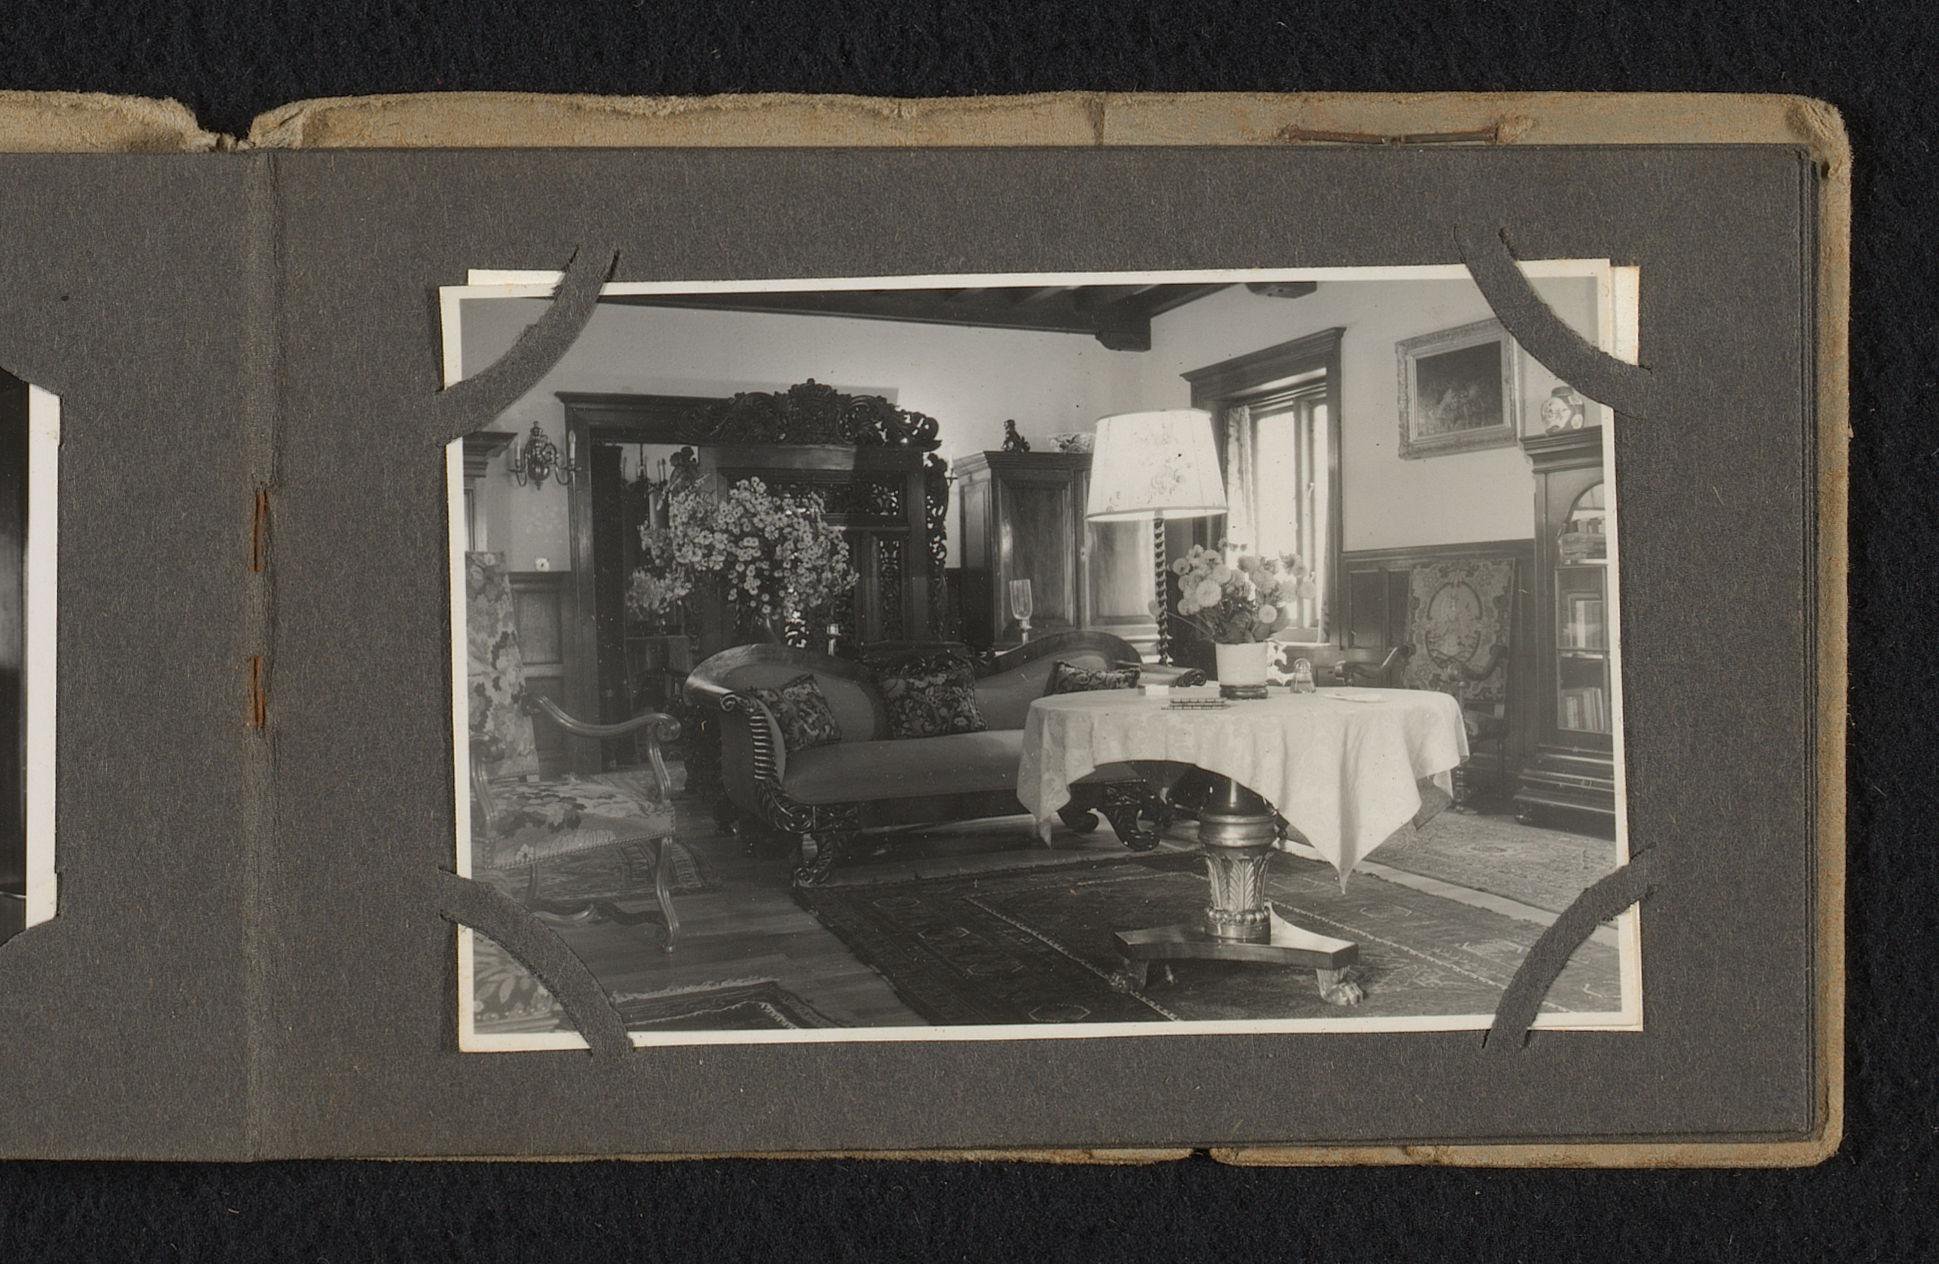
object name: photograph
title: Interieur van het landhuis De Wilde Zwanen te Laren, met een sofa en tafel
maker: norbert van den berg (1901-1972)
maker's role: amateurfotograaf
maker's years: 1901-1972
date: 1940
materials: paper, cardboard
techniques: gelatin silver print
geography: laren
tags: table, interior of the house, couch, sofa, settee